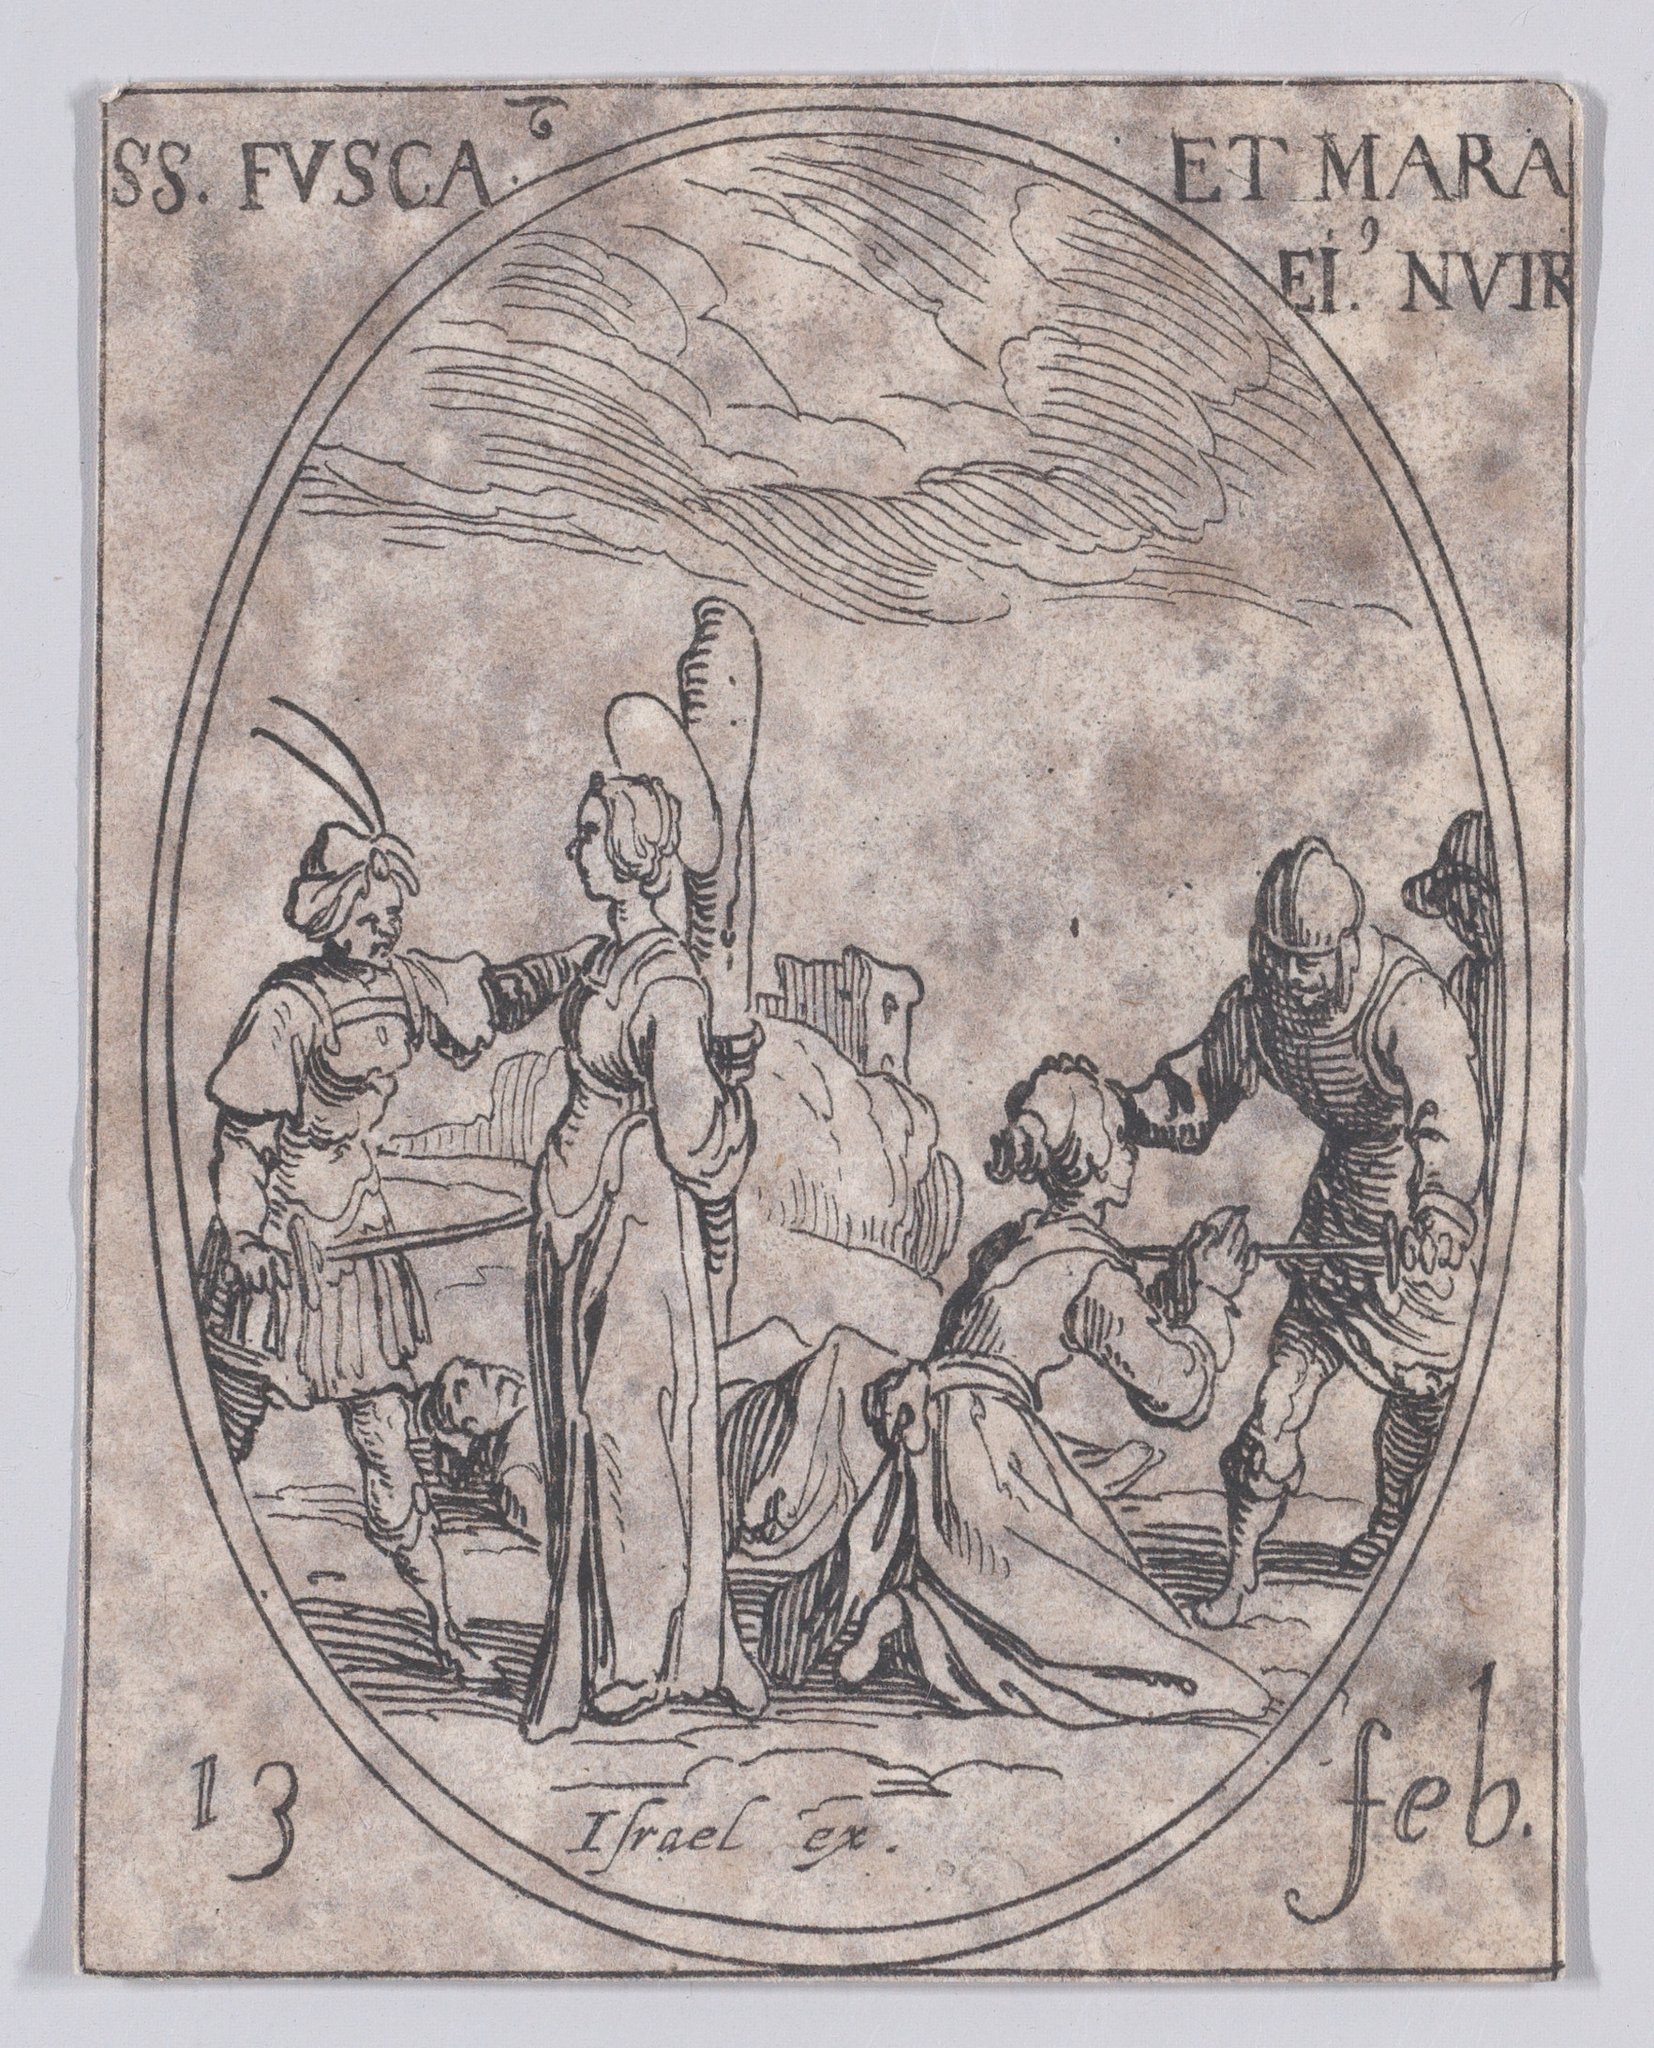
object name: print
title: Ste. Fusque et St. Maure, sa nourrice (St. Fusca and St. Maura, Her Nurse), February 13th, from "Les Images De Tous Les Saincts et Saintes de L'Année" (Images of All of the Saints and Religious Events of the Year)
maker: jacques callot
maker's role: artist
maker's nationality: french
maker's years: 1592-1635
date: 1636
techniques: etching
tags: men,women,saints